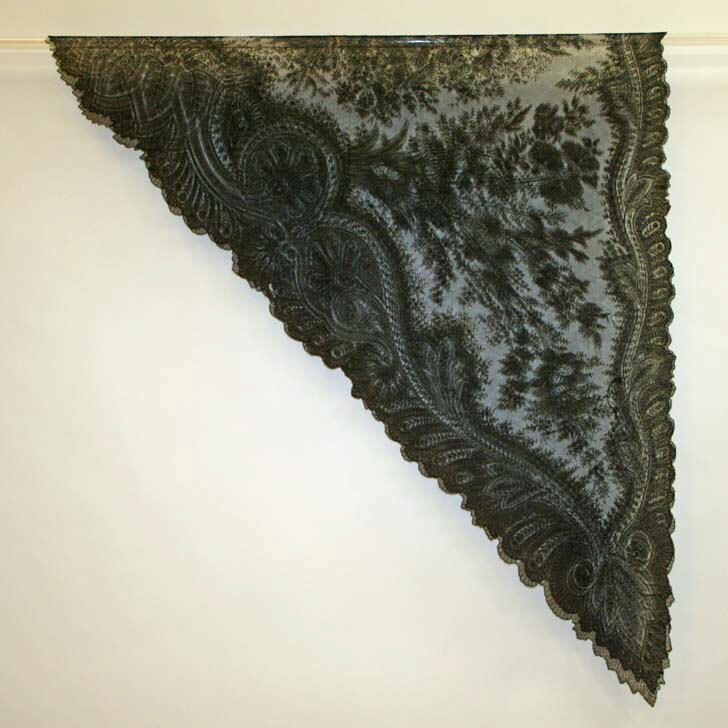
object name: shawl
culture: american or european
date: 1870-1892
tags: flowers